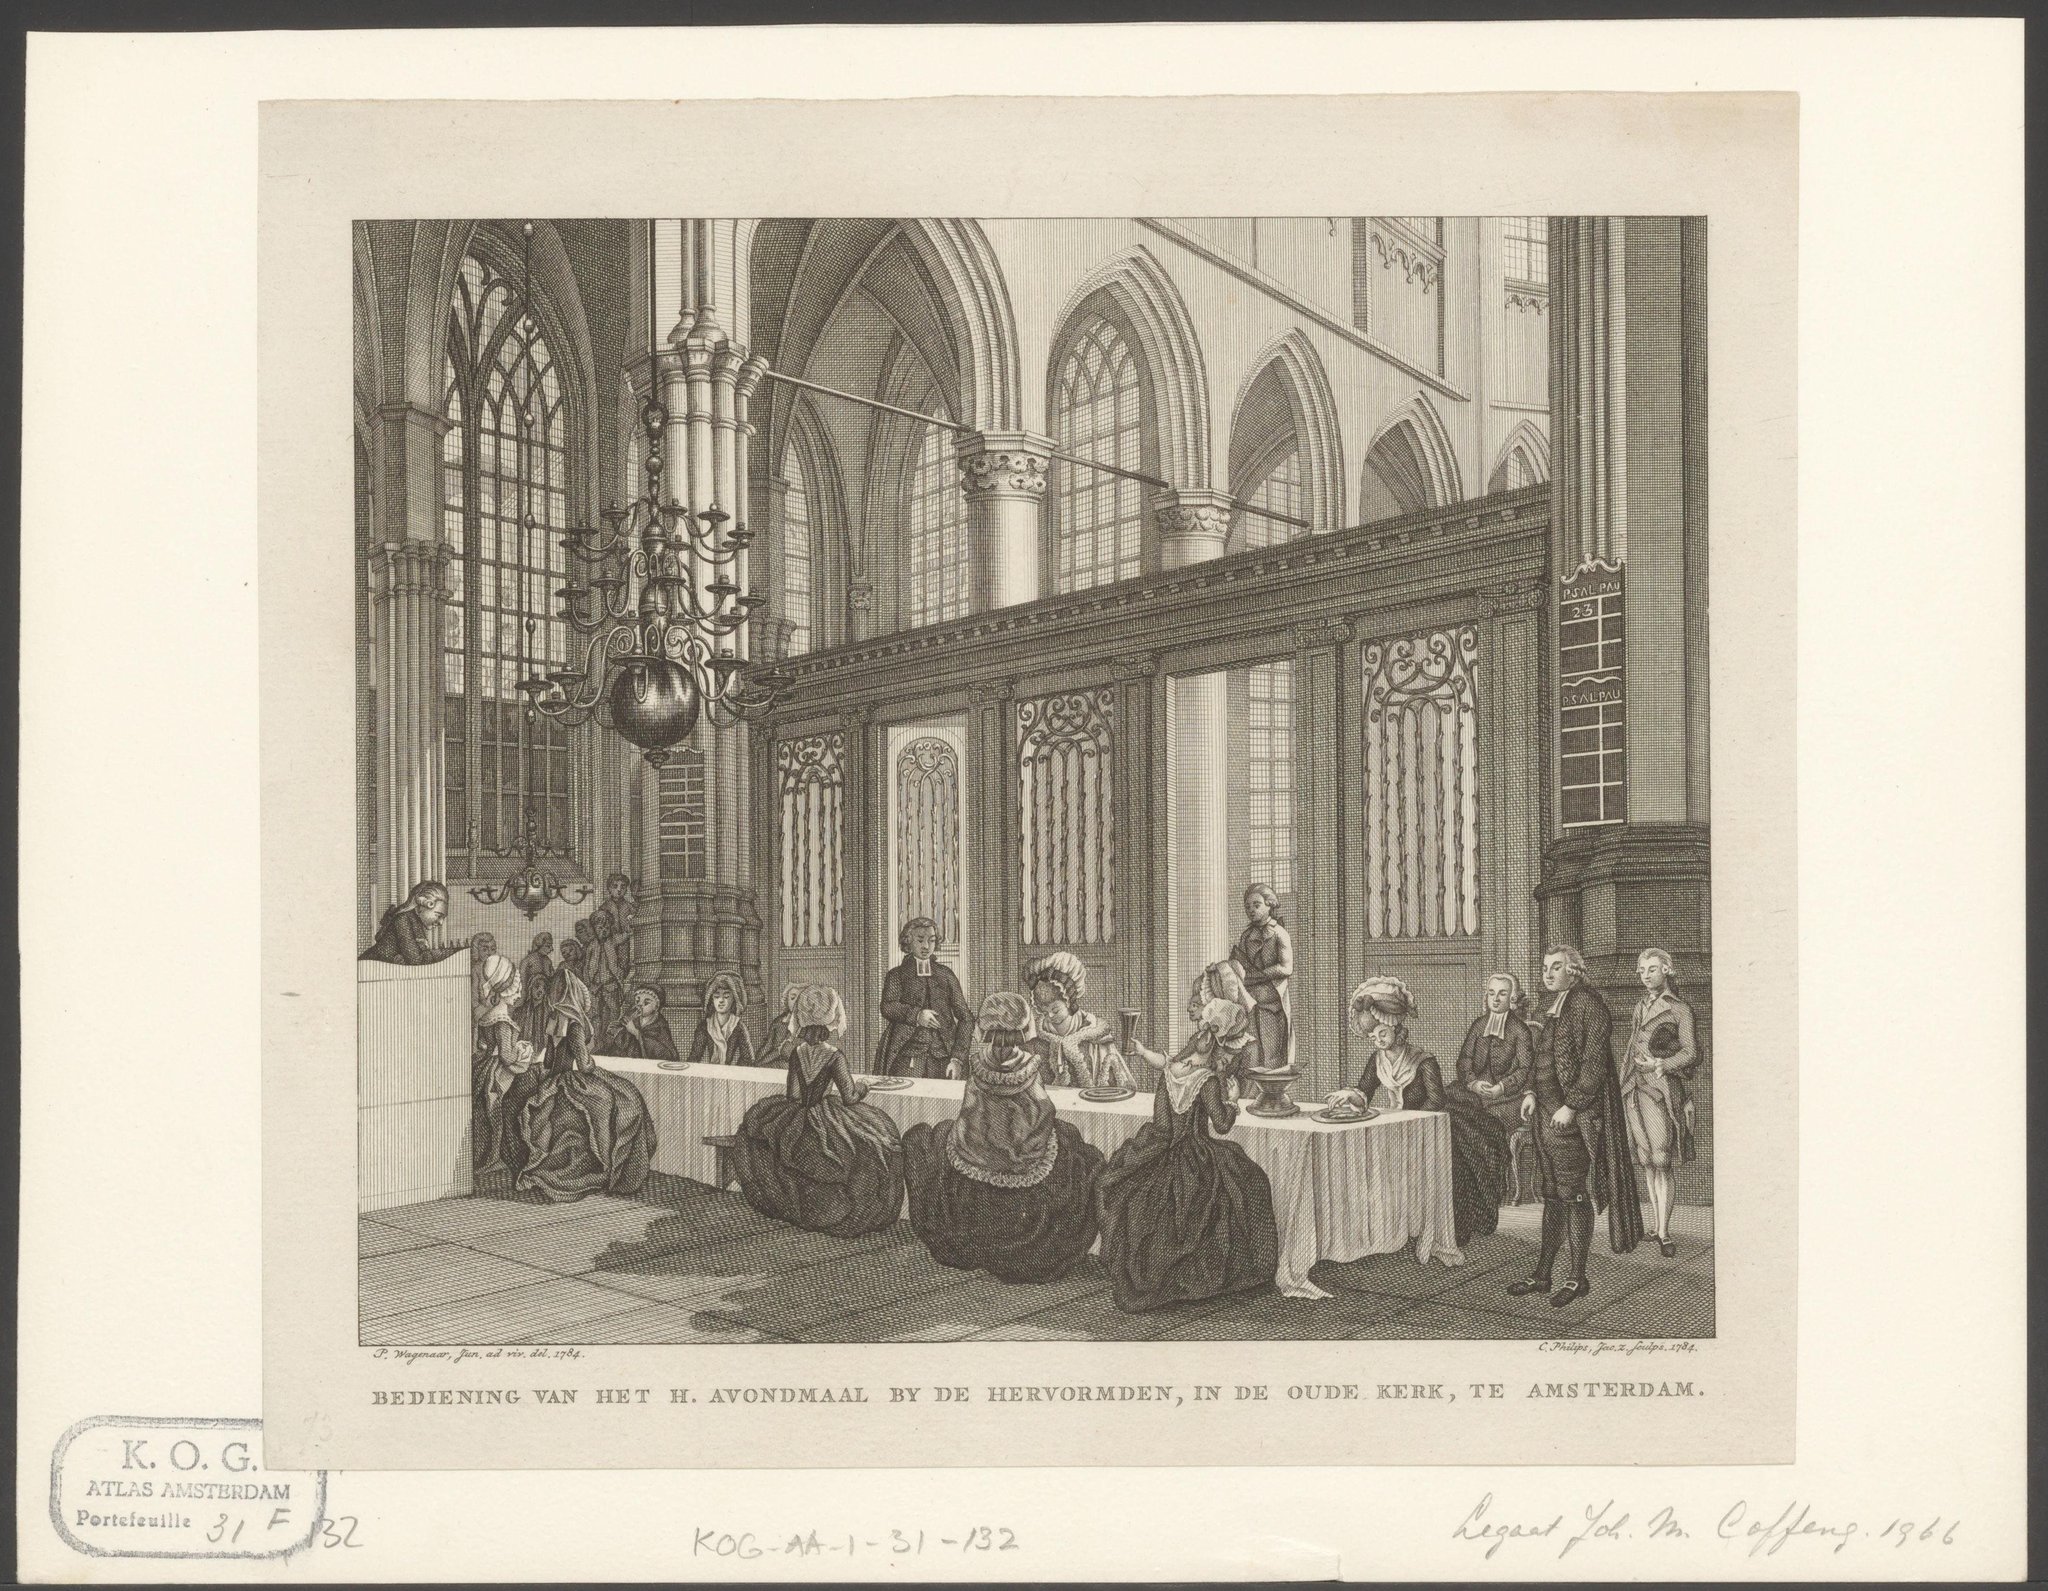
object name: print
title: Heilig avondmaal voor de hervormden in de Oude Kerk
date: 1784-1785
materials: paper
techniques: etching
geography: amsterdam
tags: evening meal, dinner, supper, prayer at table, saying grace, parts of church interior: choir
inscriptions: collector's mark: ‘31F,132’ Lugt 1641b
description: Prent waarschijnlijk uit: Hurd, William. Oude en tegenwoordige Staat en geschiedenis van alle godsdiensten (...). Amsterdam: Martinus de Bruyn, 1785, dl. 6.